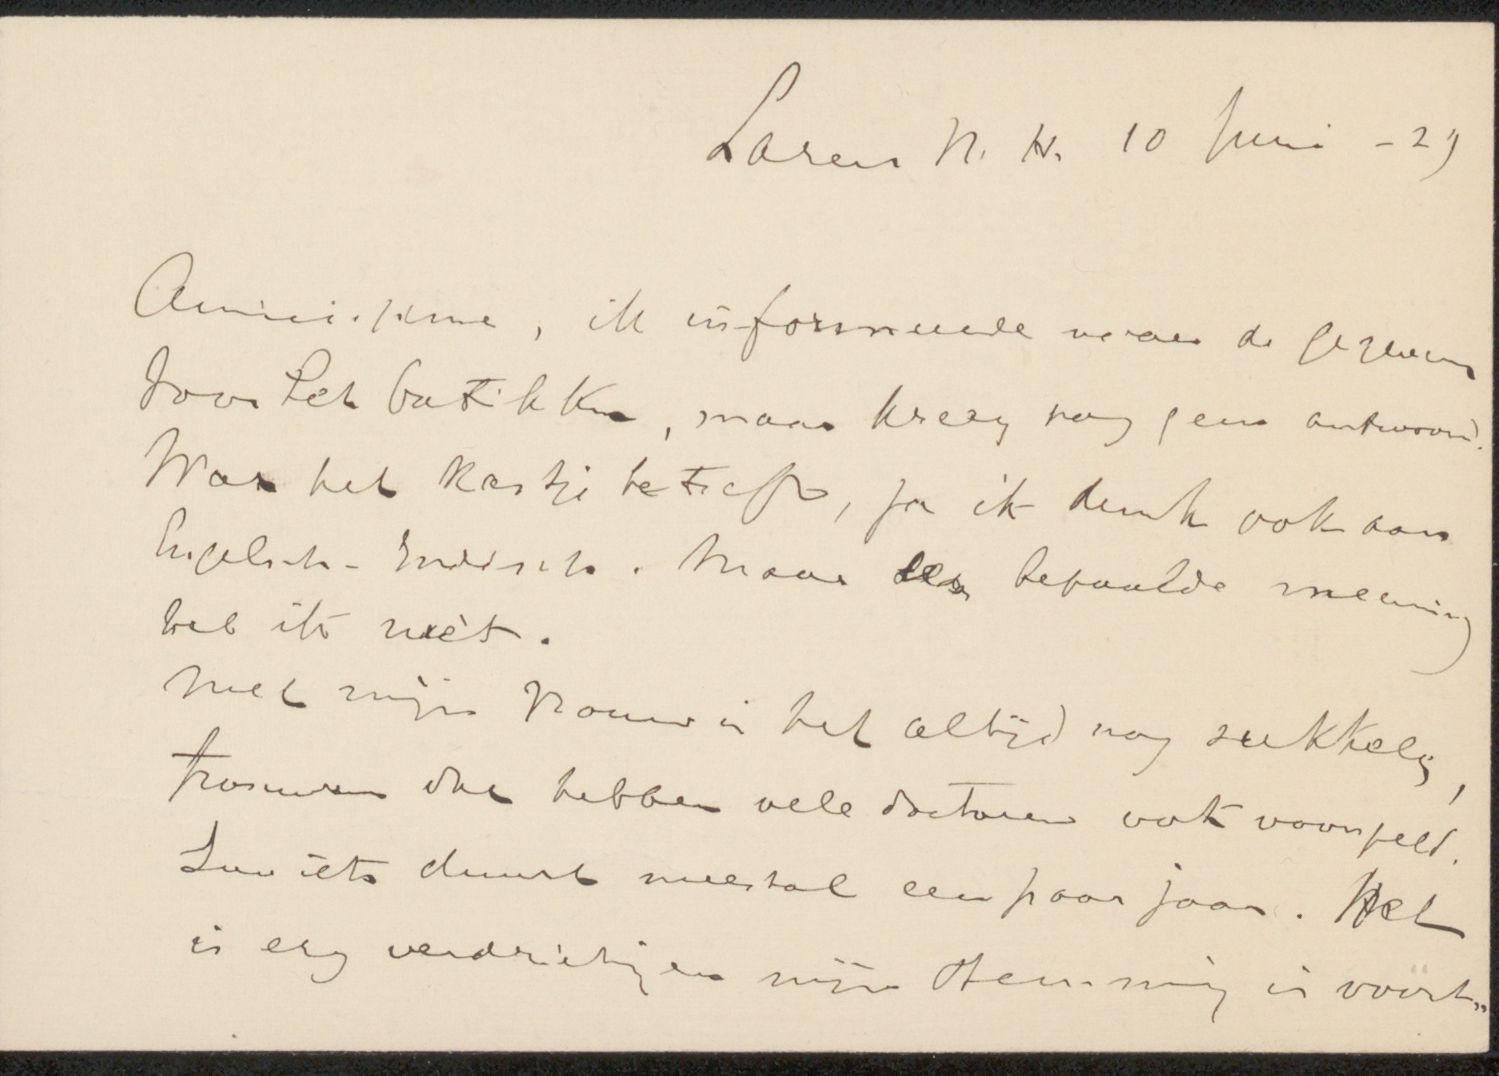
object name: letter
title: Brief aan Philip Zilcken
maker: adriaan pit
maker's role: print maker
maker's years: 1860-1944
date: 1929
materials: cardboard, ink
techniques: pen, writing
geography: laren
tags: painter, draughtsman, philip zilcken, passions, emotions, affections, applied arts, arts and crafts; industrial design, diseases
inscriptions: collector's mark: ‘RPK’